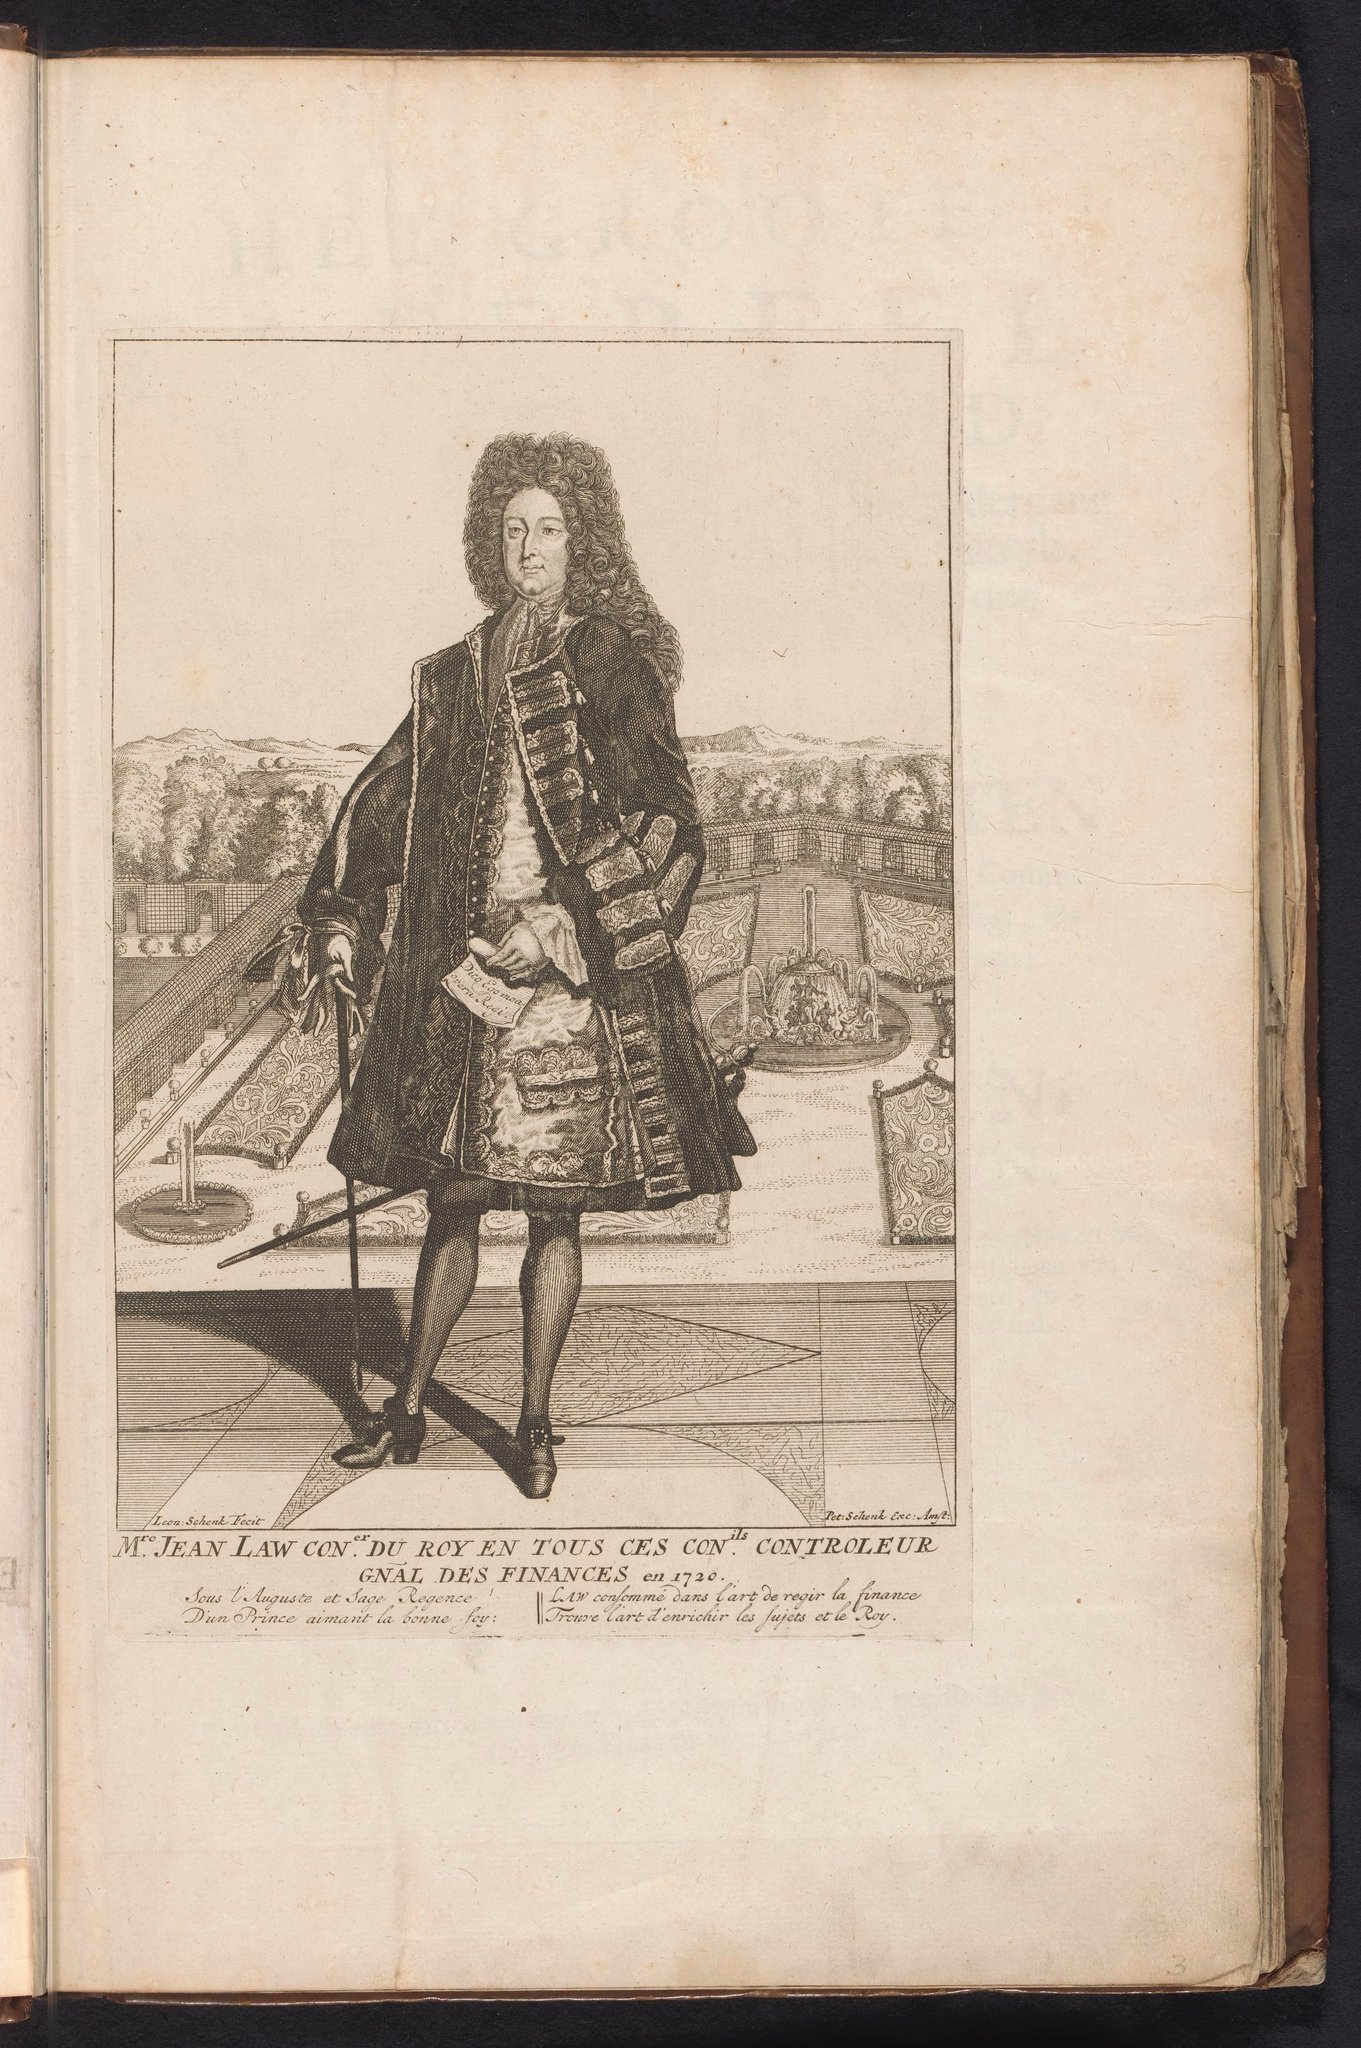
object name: print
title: Het Groote Tafereel der Dwaasheid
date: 1720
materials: paper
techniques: etching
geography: amsterdam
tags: econoom, john law, windhandel van 1720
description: Portret van John Law, staande ten voeten uit, op de achtergrond een tuin met fontein. In het onderschrift een vierregelig vers in het Frans. Blad (uitgeknipt en opgeplakt) in de gebonden eerste uitgave (304 B 11) van Het Groote Tafereel der Dwaasheid met spotprenten op de Windhandel of Actiehandel van 1720.